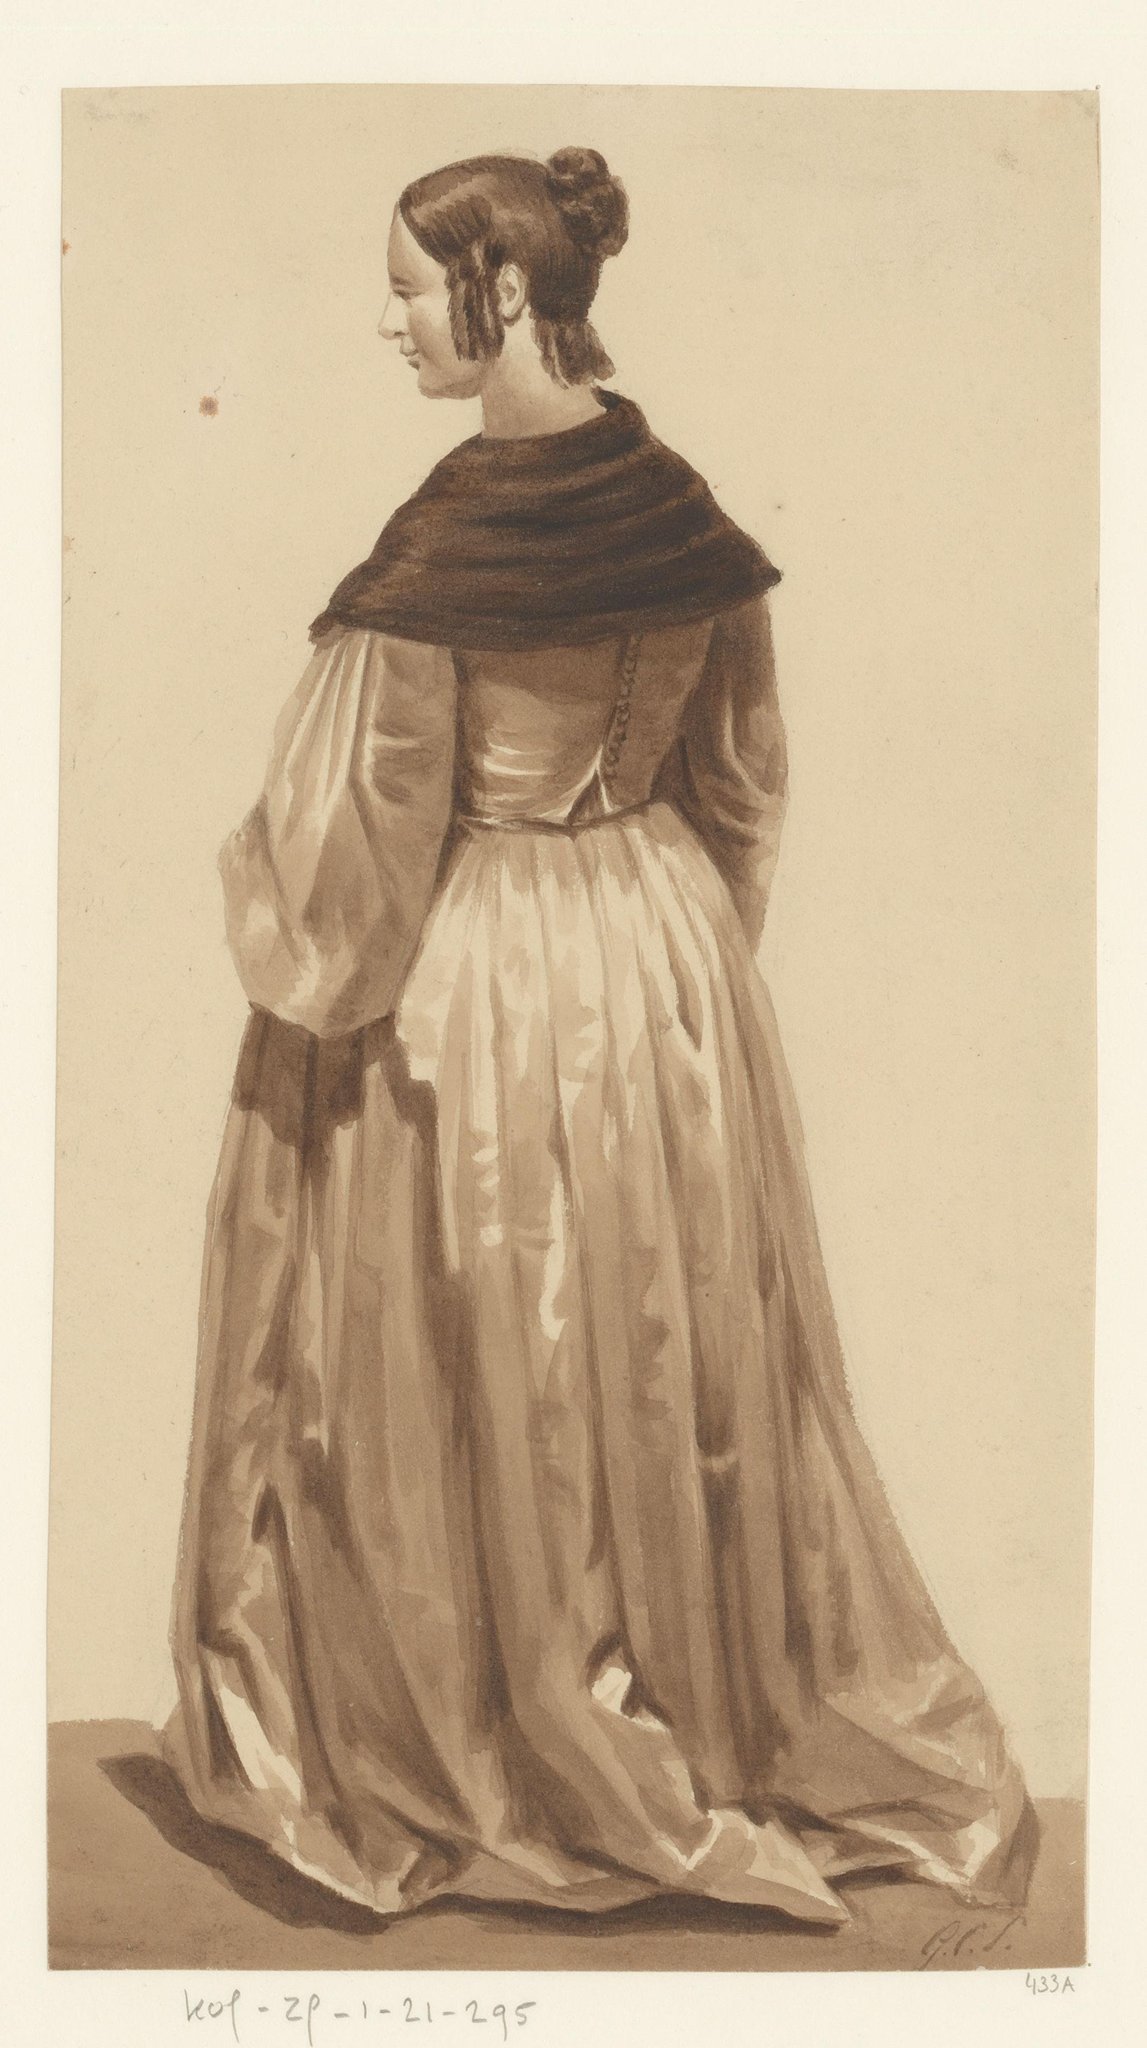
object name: drawing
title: Staande dame in een lange jurk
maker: Anonymous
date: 1830-1899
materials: ink, paper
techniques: brush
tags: fashion, clothing, standing figure, adult woman, dress, gown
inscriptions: signature: ‘G.C.L.’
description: Onderwerpsrubrieken binnen de Atlas Zeden en Gewoonten: Zeden en Gewoonten in Engeren Zin, De Kleeding, Kleederdrachten (tijdvakken), Het midden der 19de eeuw. Mannen en vrouwen.